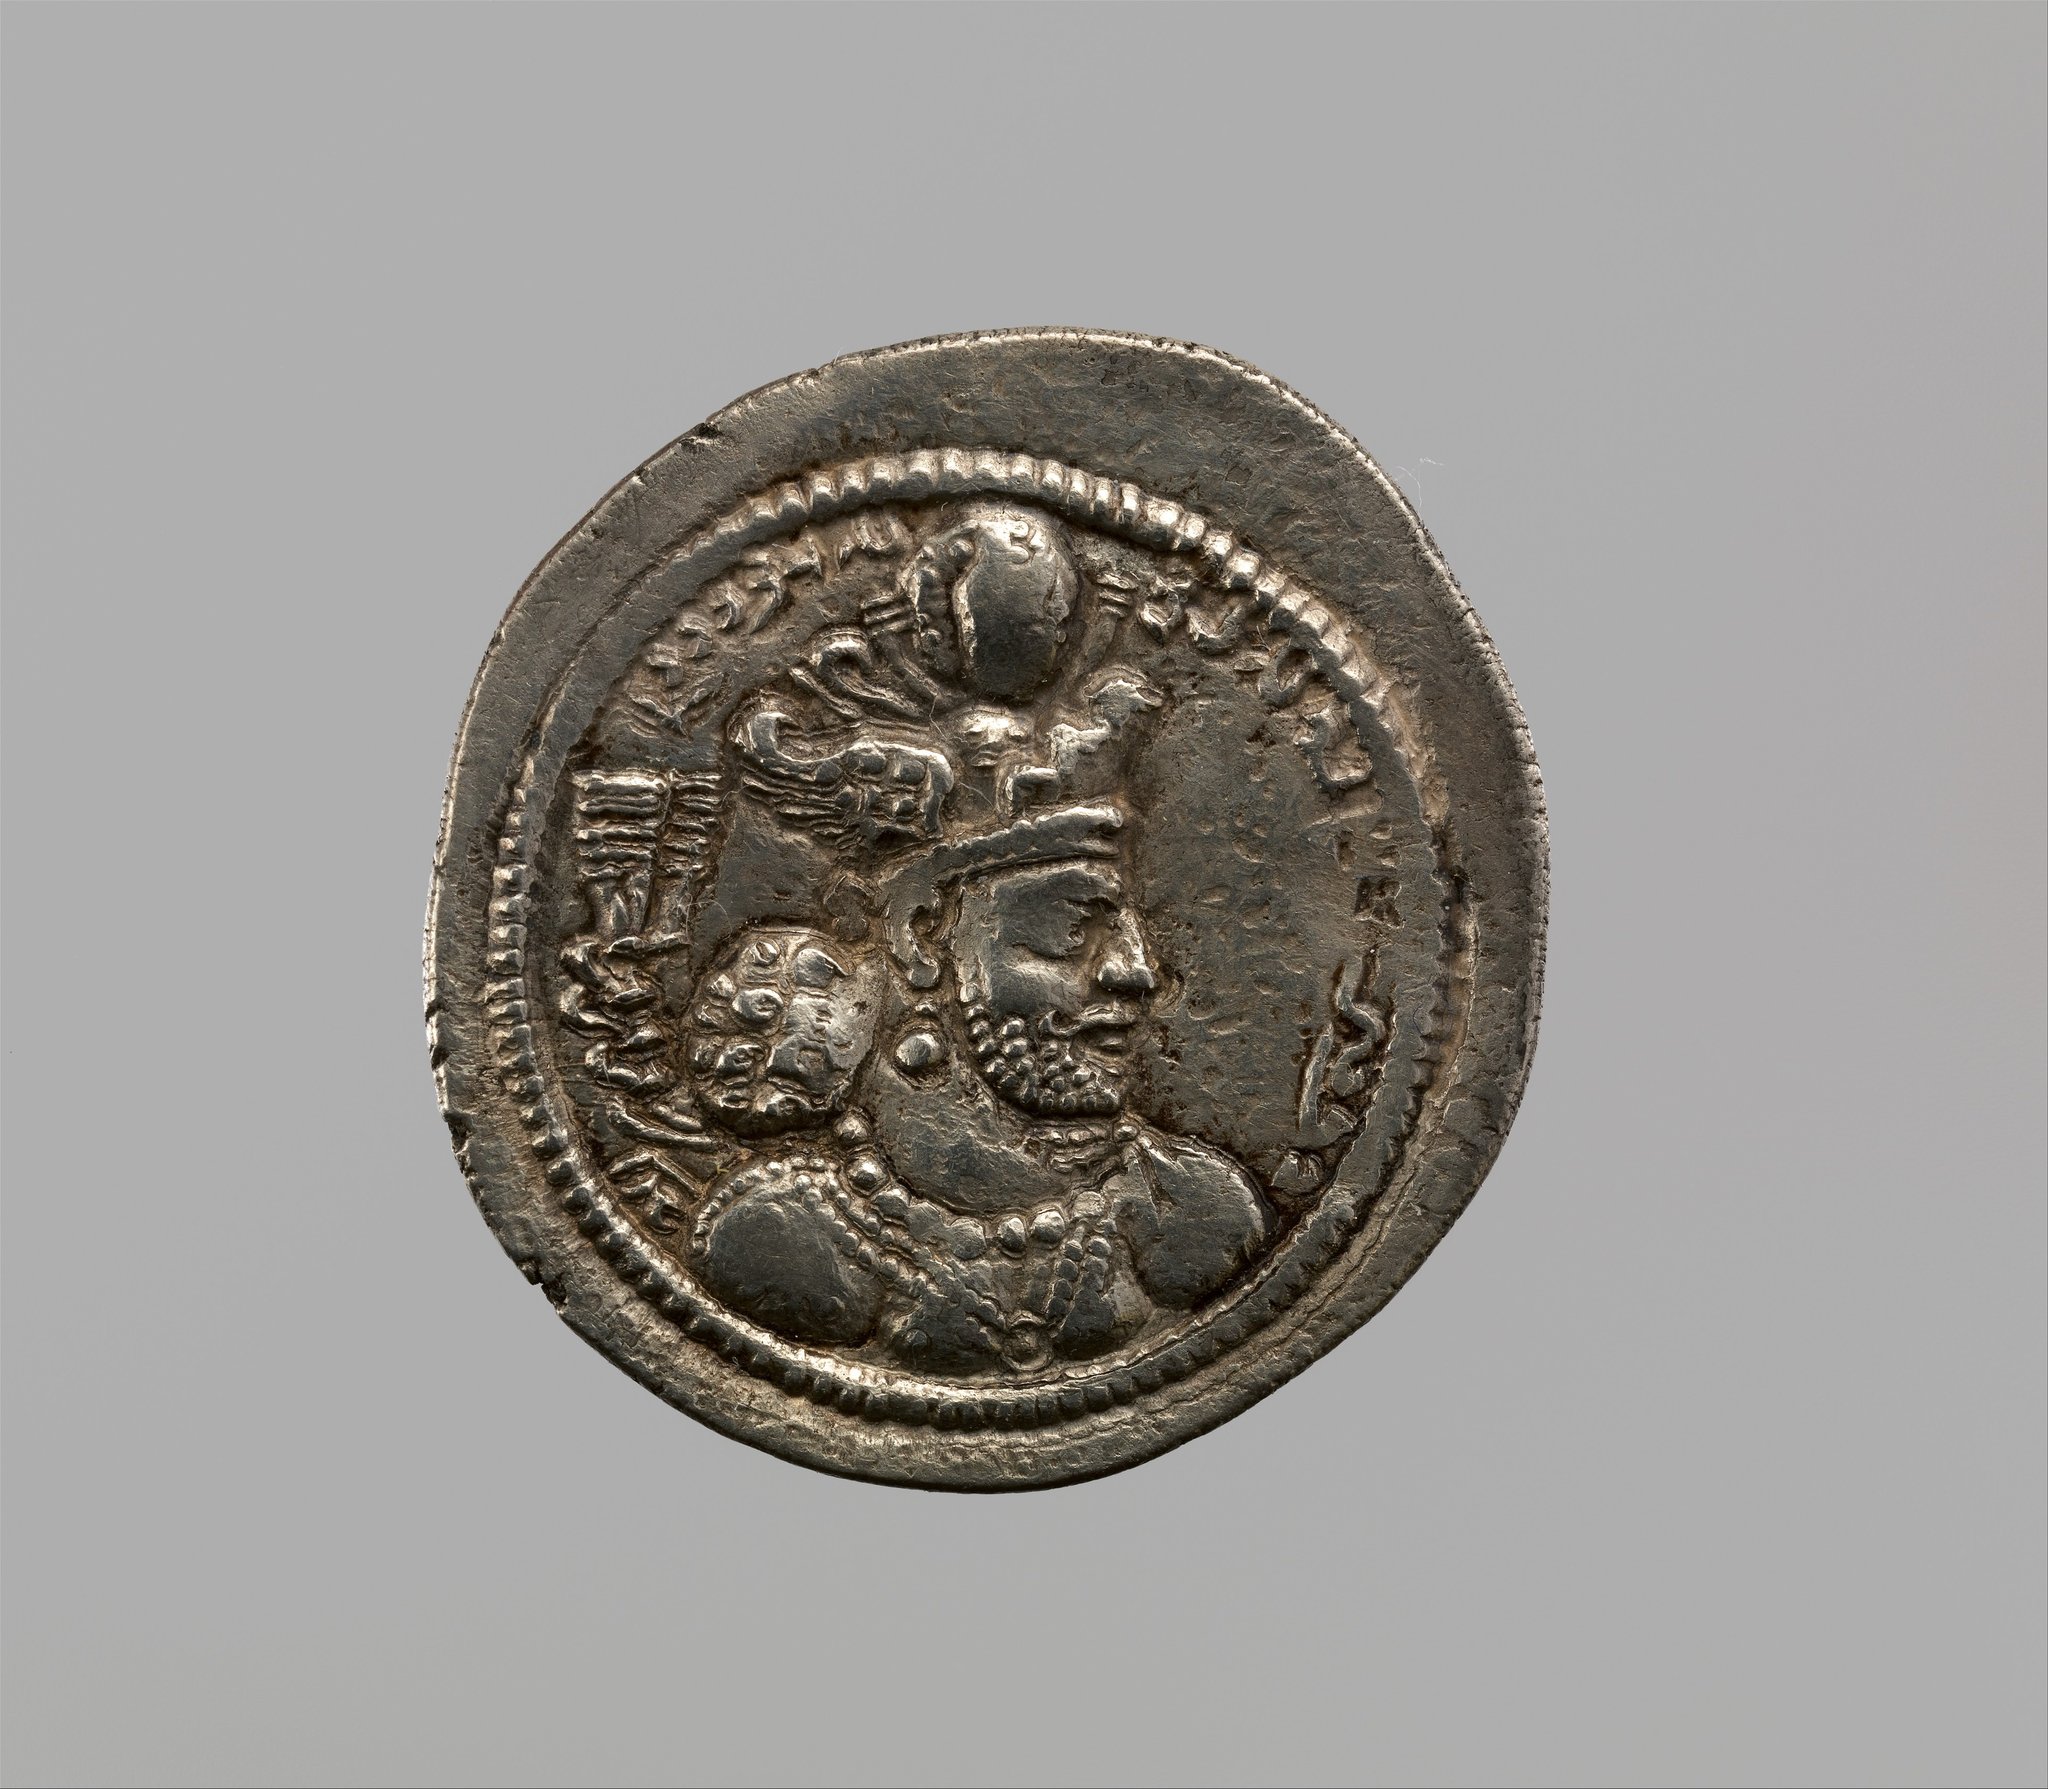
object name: coin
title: Drachm of Bahram IV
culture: sasanian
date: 388-399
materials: silver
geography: iran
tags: kings,men